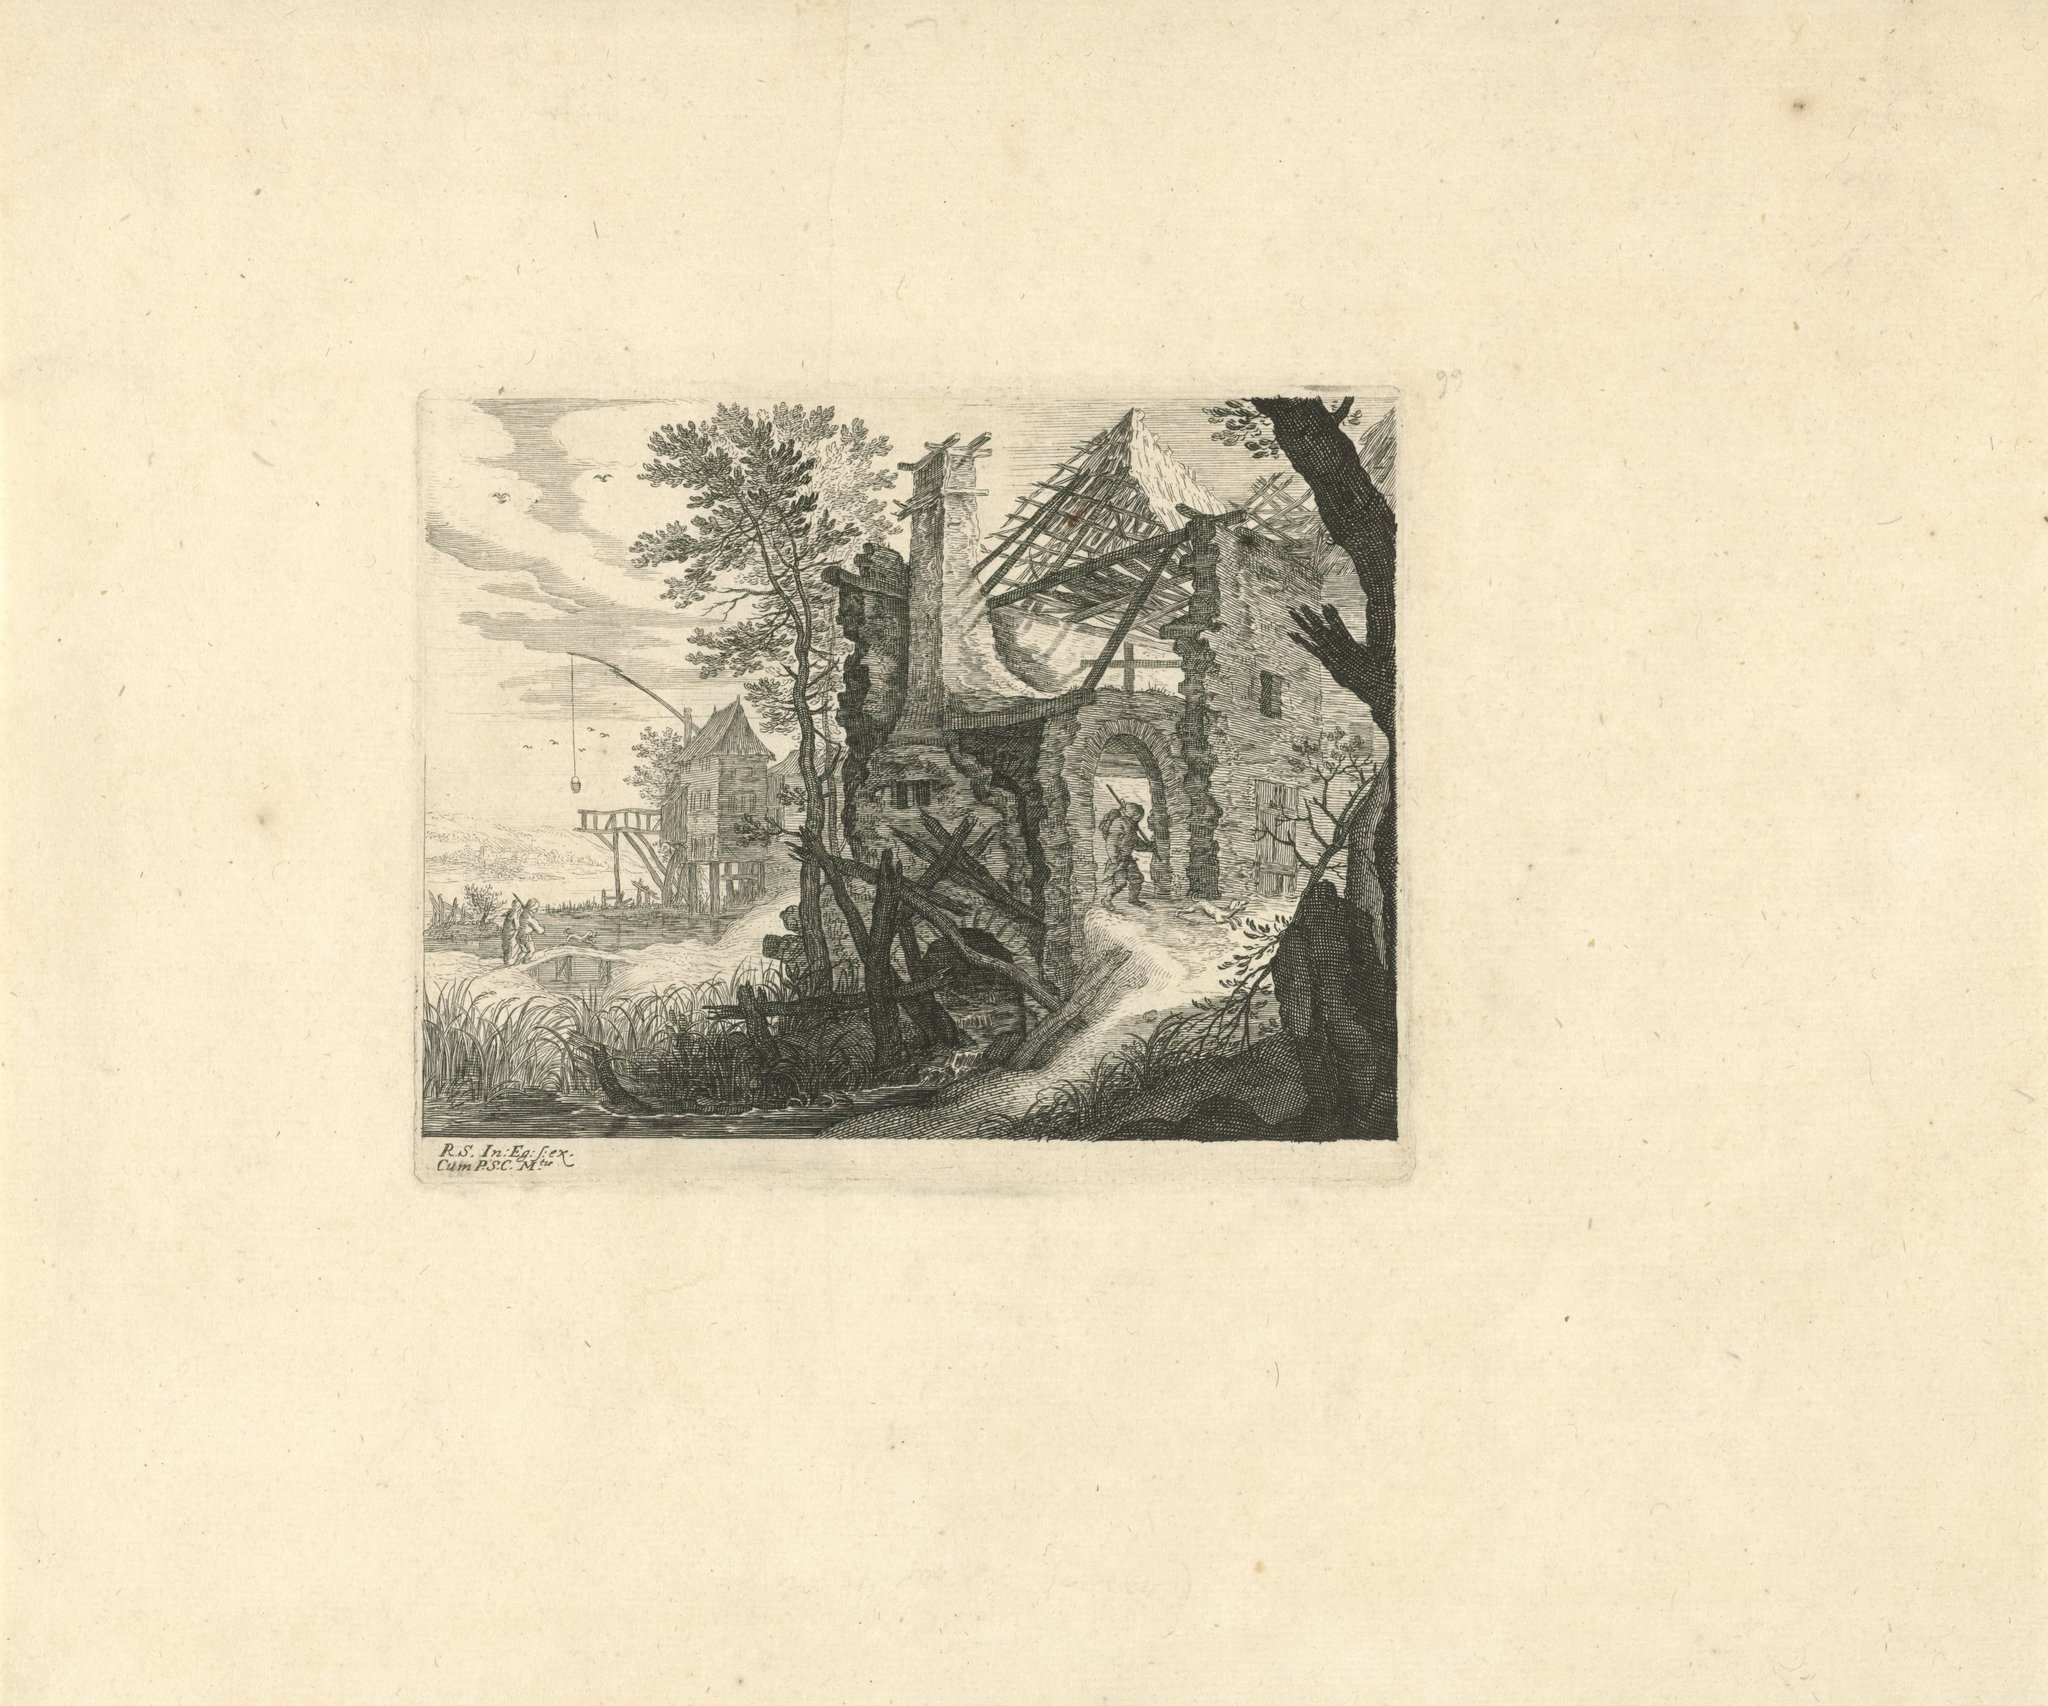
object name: print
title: Ruïne in een landschap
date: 1597-1629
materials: paper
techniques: engraving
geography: prague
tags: inn, coffee-house, public house, etc., landscape with ruins (+ city(-scape) with figures, staffage)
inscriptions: collector's mark: Lugt 2760, collector's mark: Lugt 2228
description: Ruïne met een reiziger. Op de achtergrond een herberg. De vierde prent van een zesdelige reeks met landschappen in Tirol